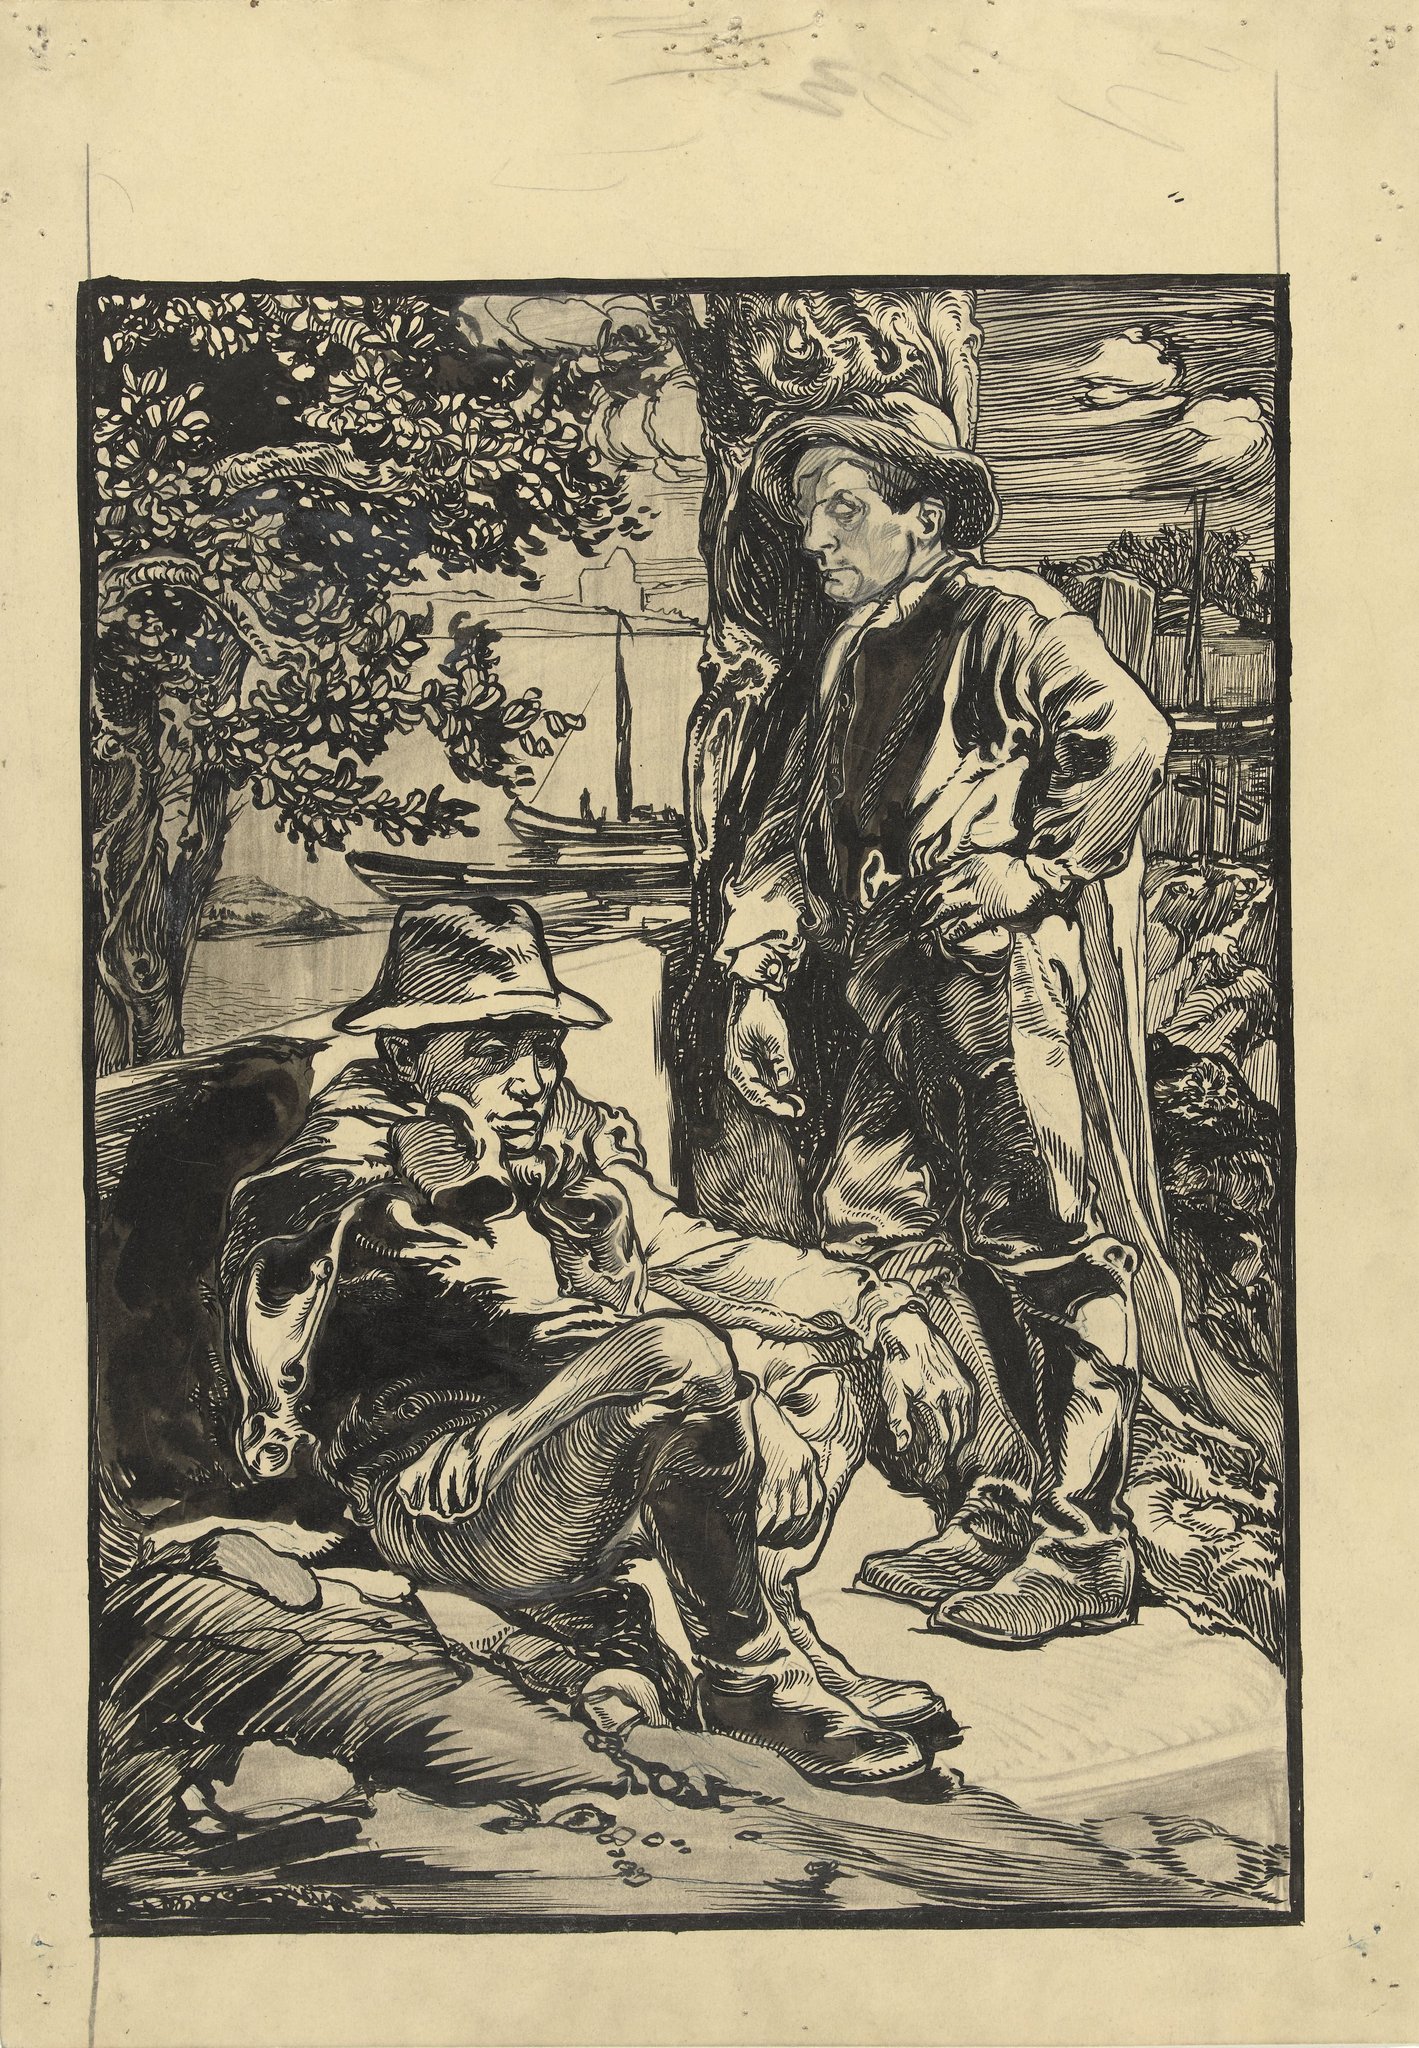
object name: drawing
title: Twee dijkwerkers, de een zittend, de ander tegen een boom geleund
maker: johannes josephus aarts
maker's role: draughtsman, print maker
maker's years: 1871-1934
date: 1881-1934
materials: charcoal, paint, ink, paper, pencil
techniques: brush, pen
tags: heaping up (industrial process), dikes, levee